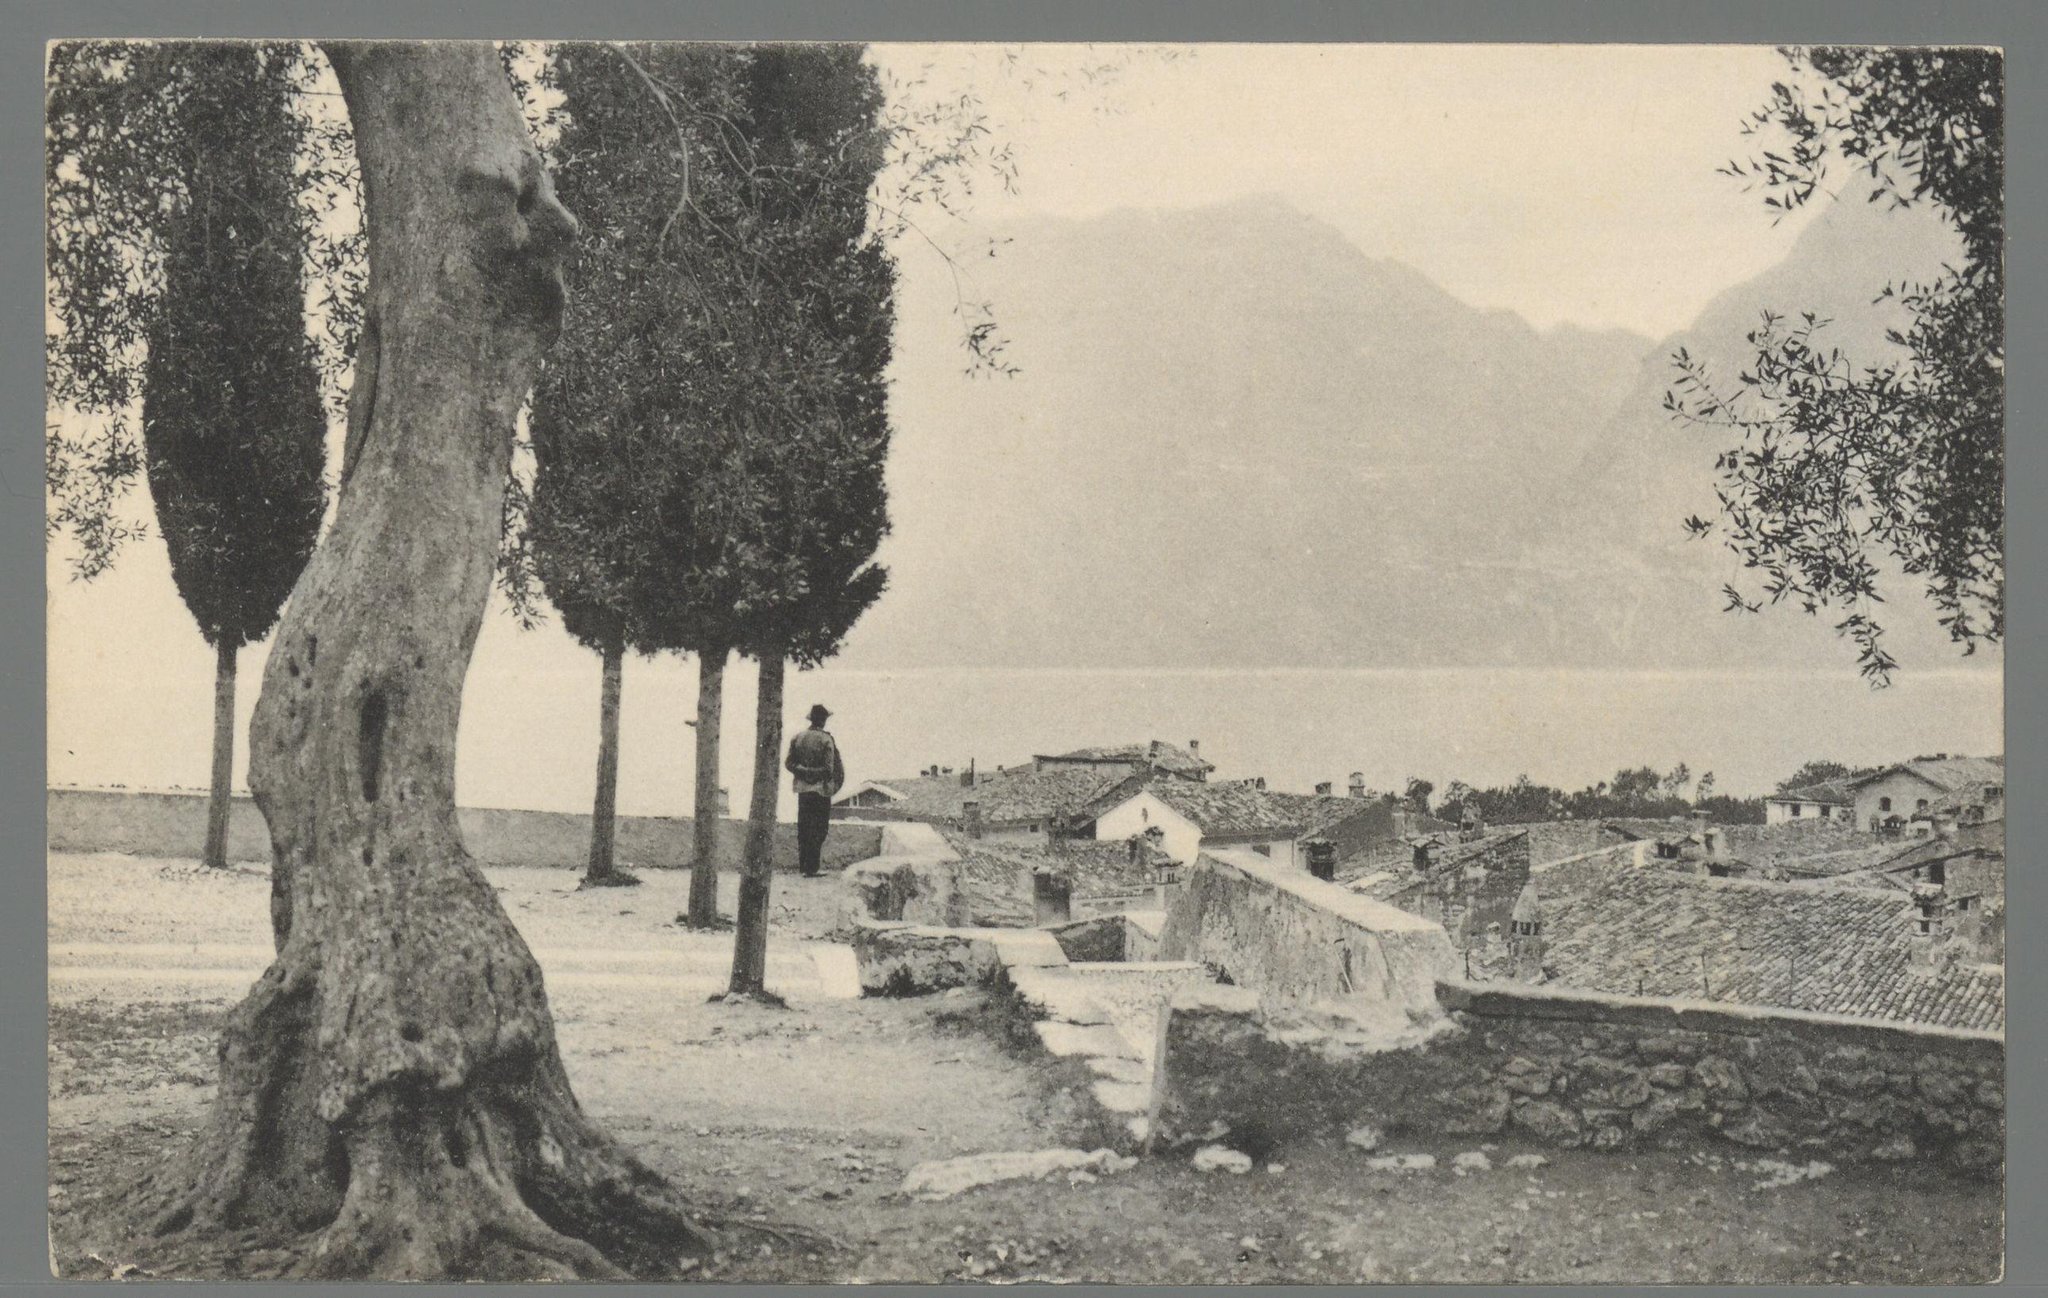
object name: photomechanical print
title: Gardasee. Torbole. Blick von der Kirche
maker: Anonymous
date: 1885-1905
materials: cardboard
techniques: photograph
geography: torbole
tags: prospect of village, silhouette of village, lake, mountains